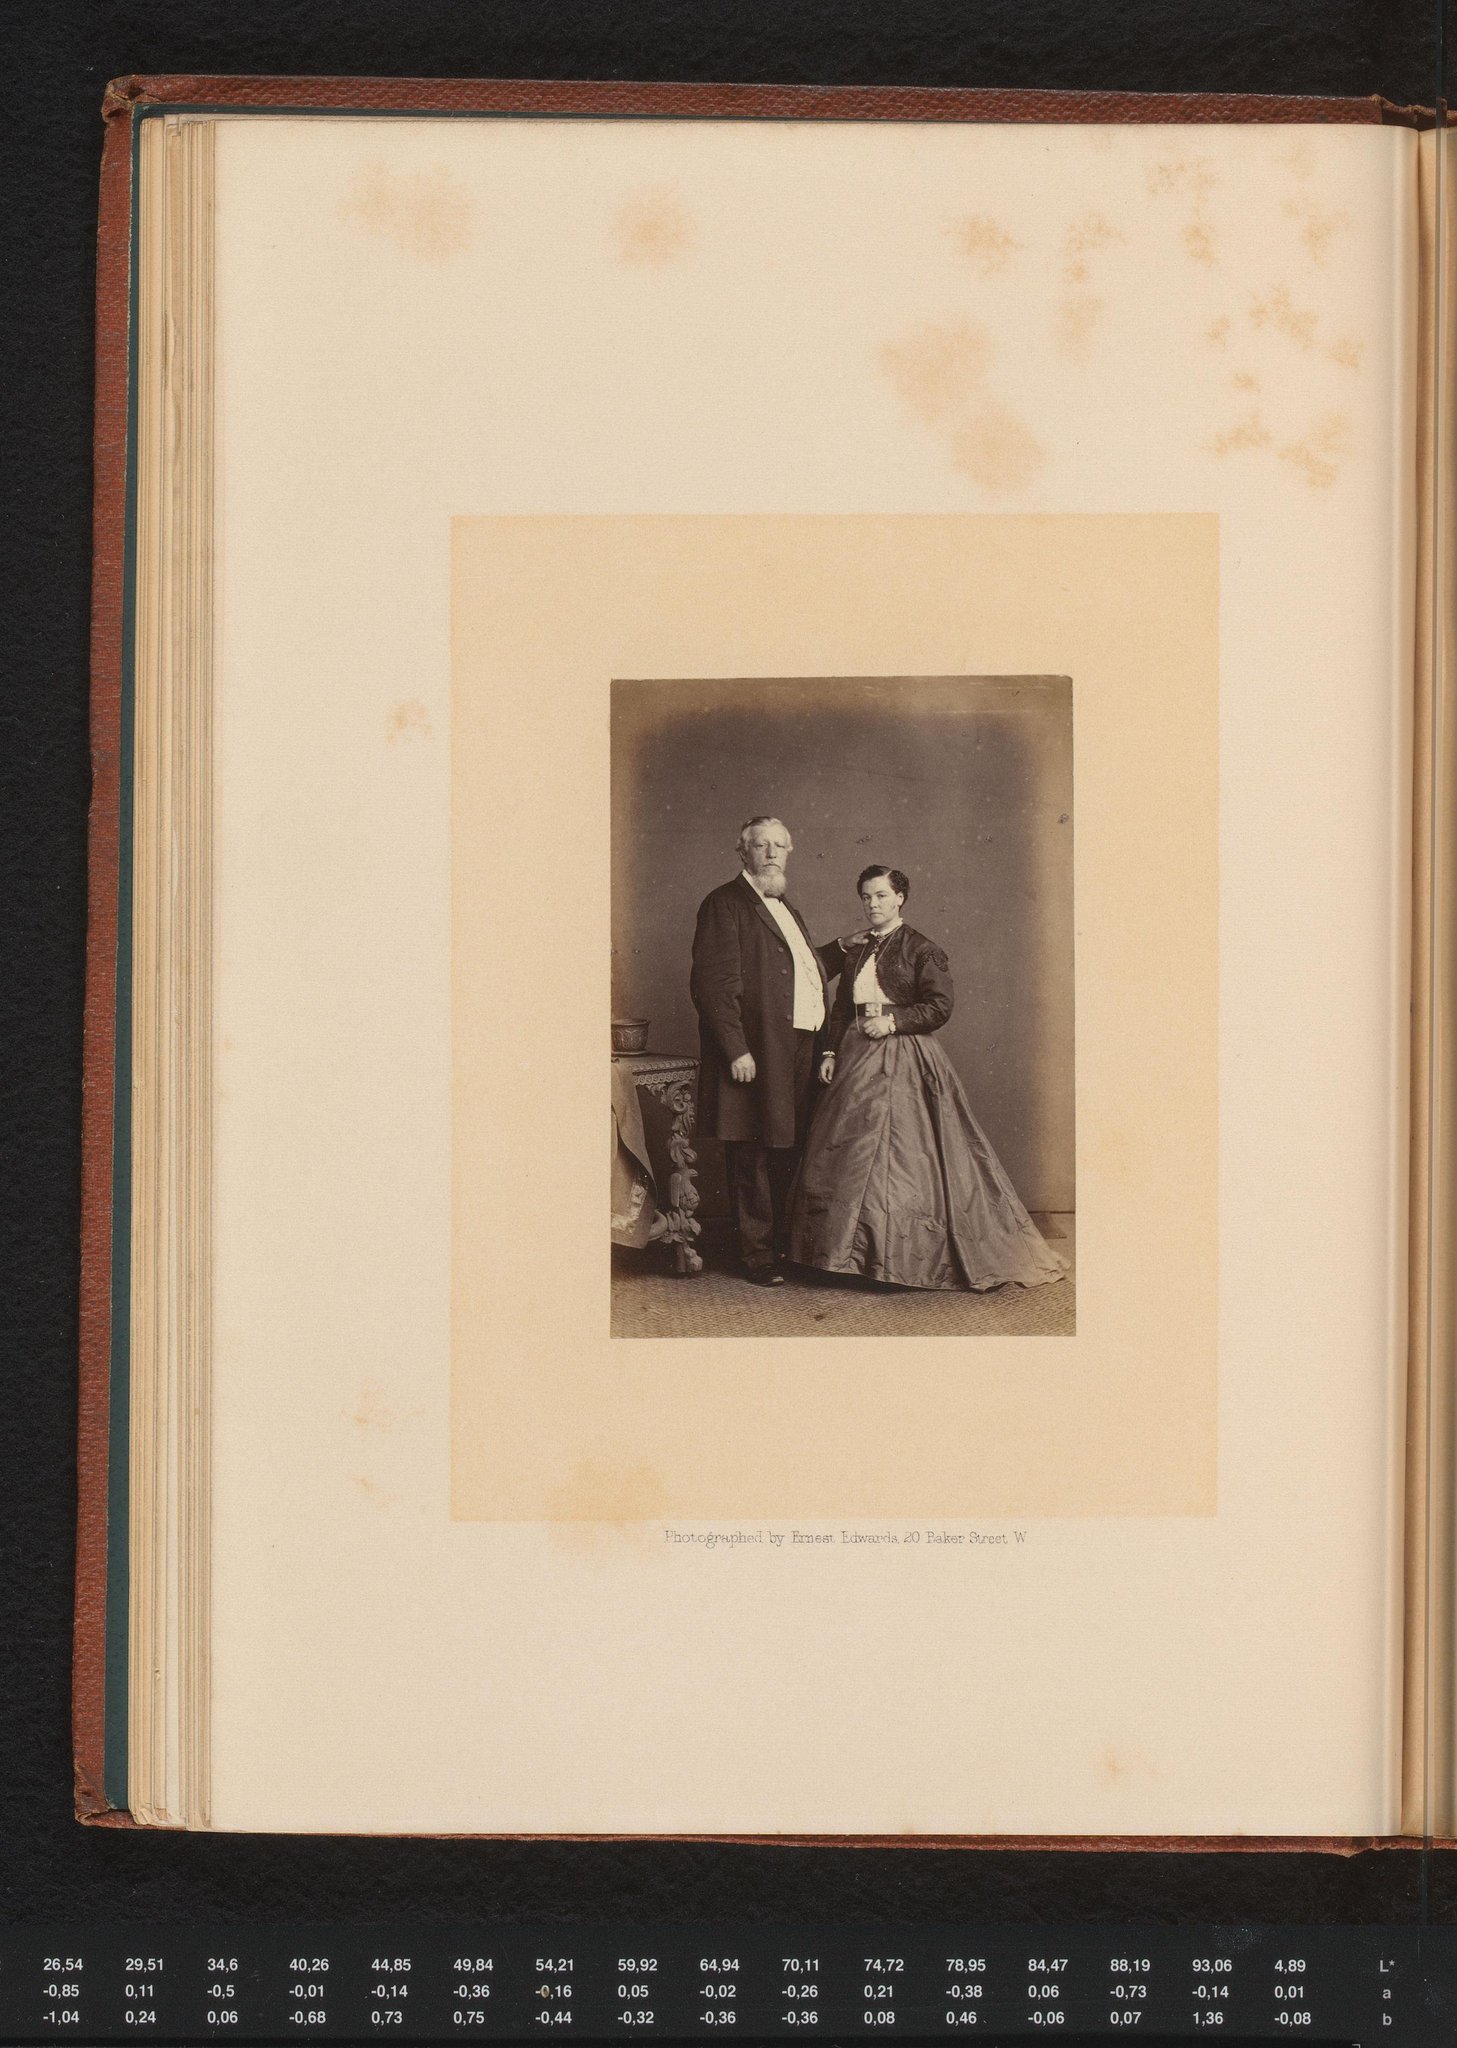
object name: page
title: Portret van Charles Tilstone Beke en Emily Beke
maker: ernest edwards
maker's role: fotograaf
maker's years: 1837-1903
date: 1857-1867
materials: paper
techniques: albumen print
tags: historical persons, marriage, married couple, 'matrimonium'